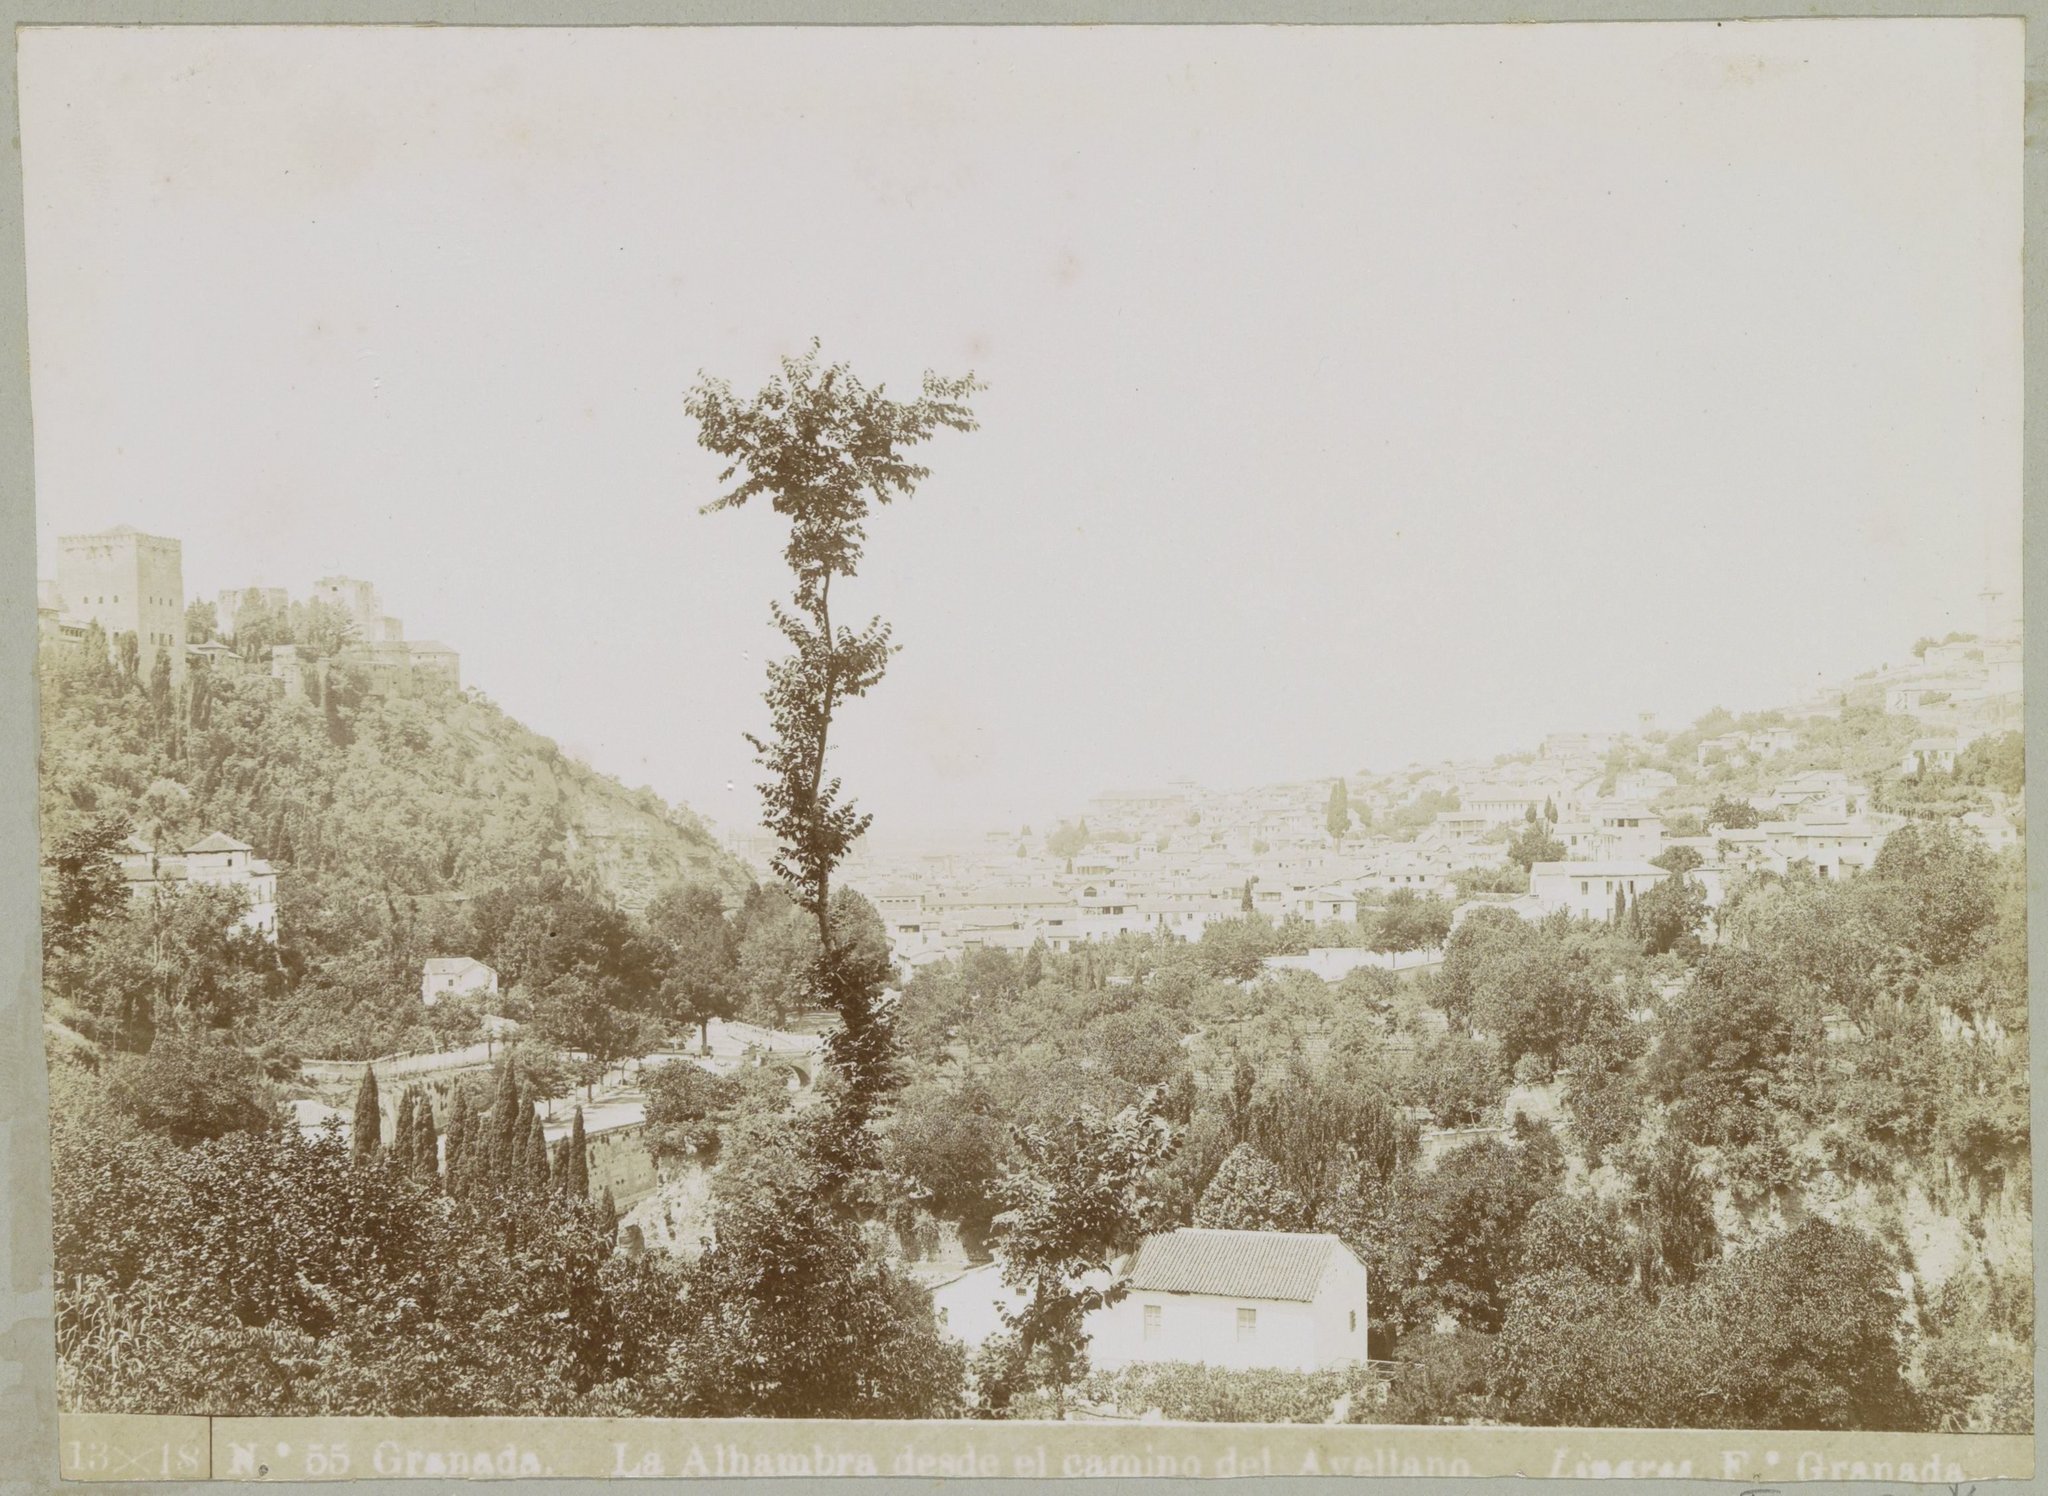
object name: photograph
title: La Alhambra desde el camino del Avellano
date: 1860-1900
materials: photographic support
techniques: daylight paper print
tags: prospect of village, silhouette of village, fortress, palace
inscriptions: number: ‘55’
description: Onderdeel van Reisalbum met opnames van het Alhambra in Granada.